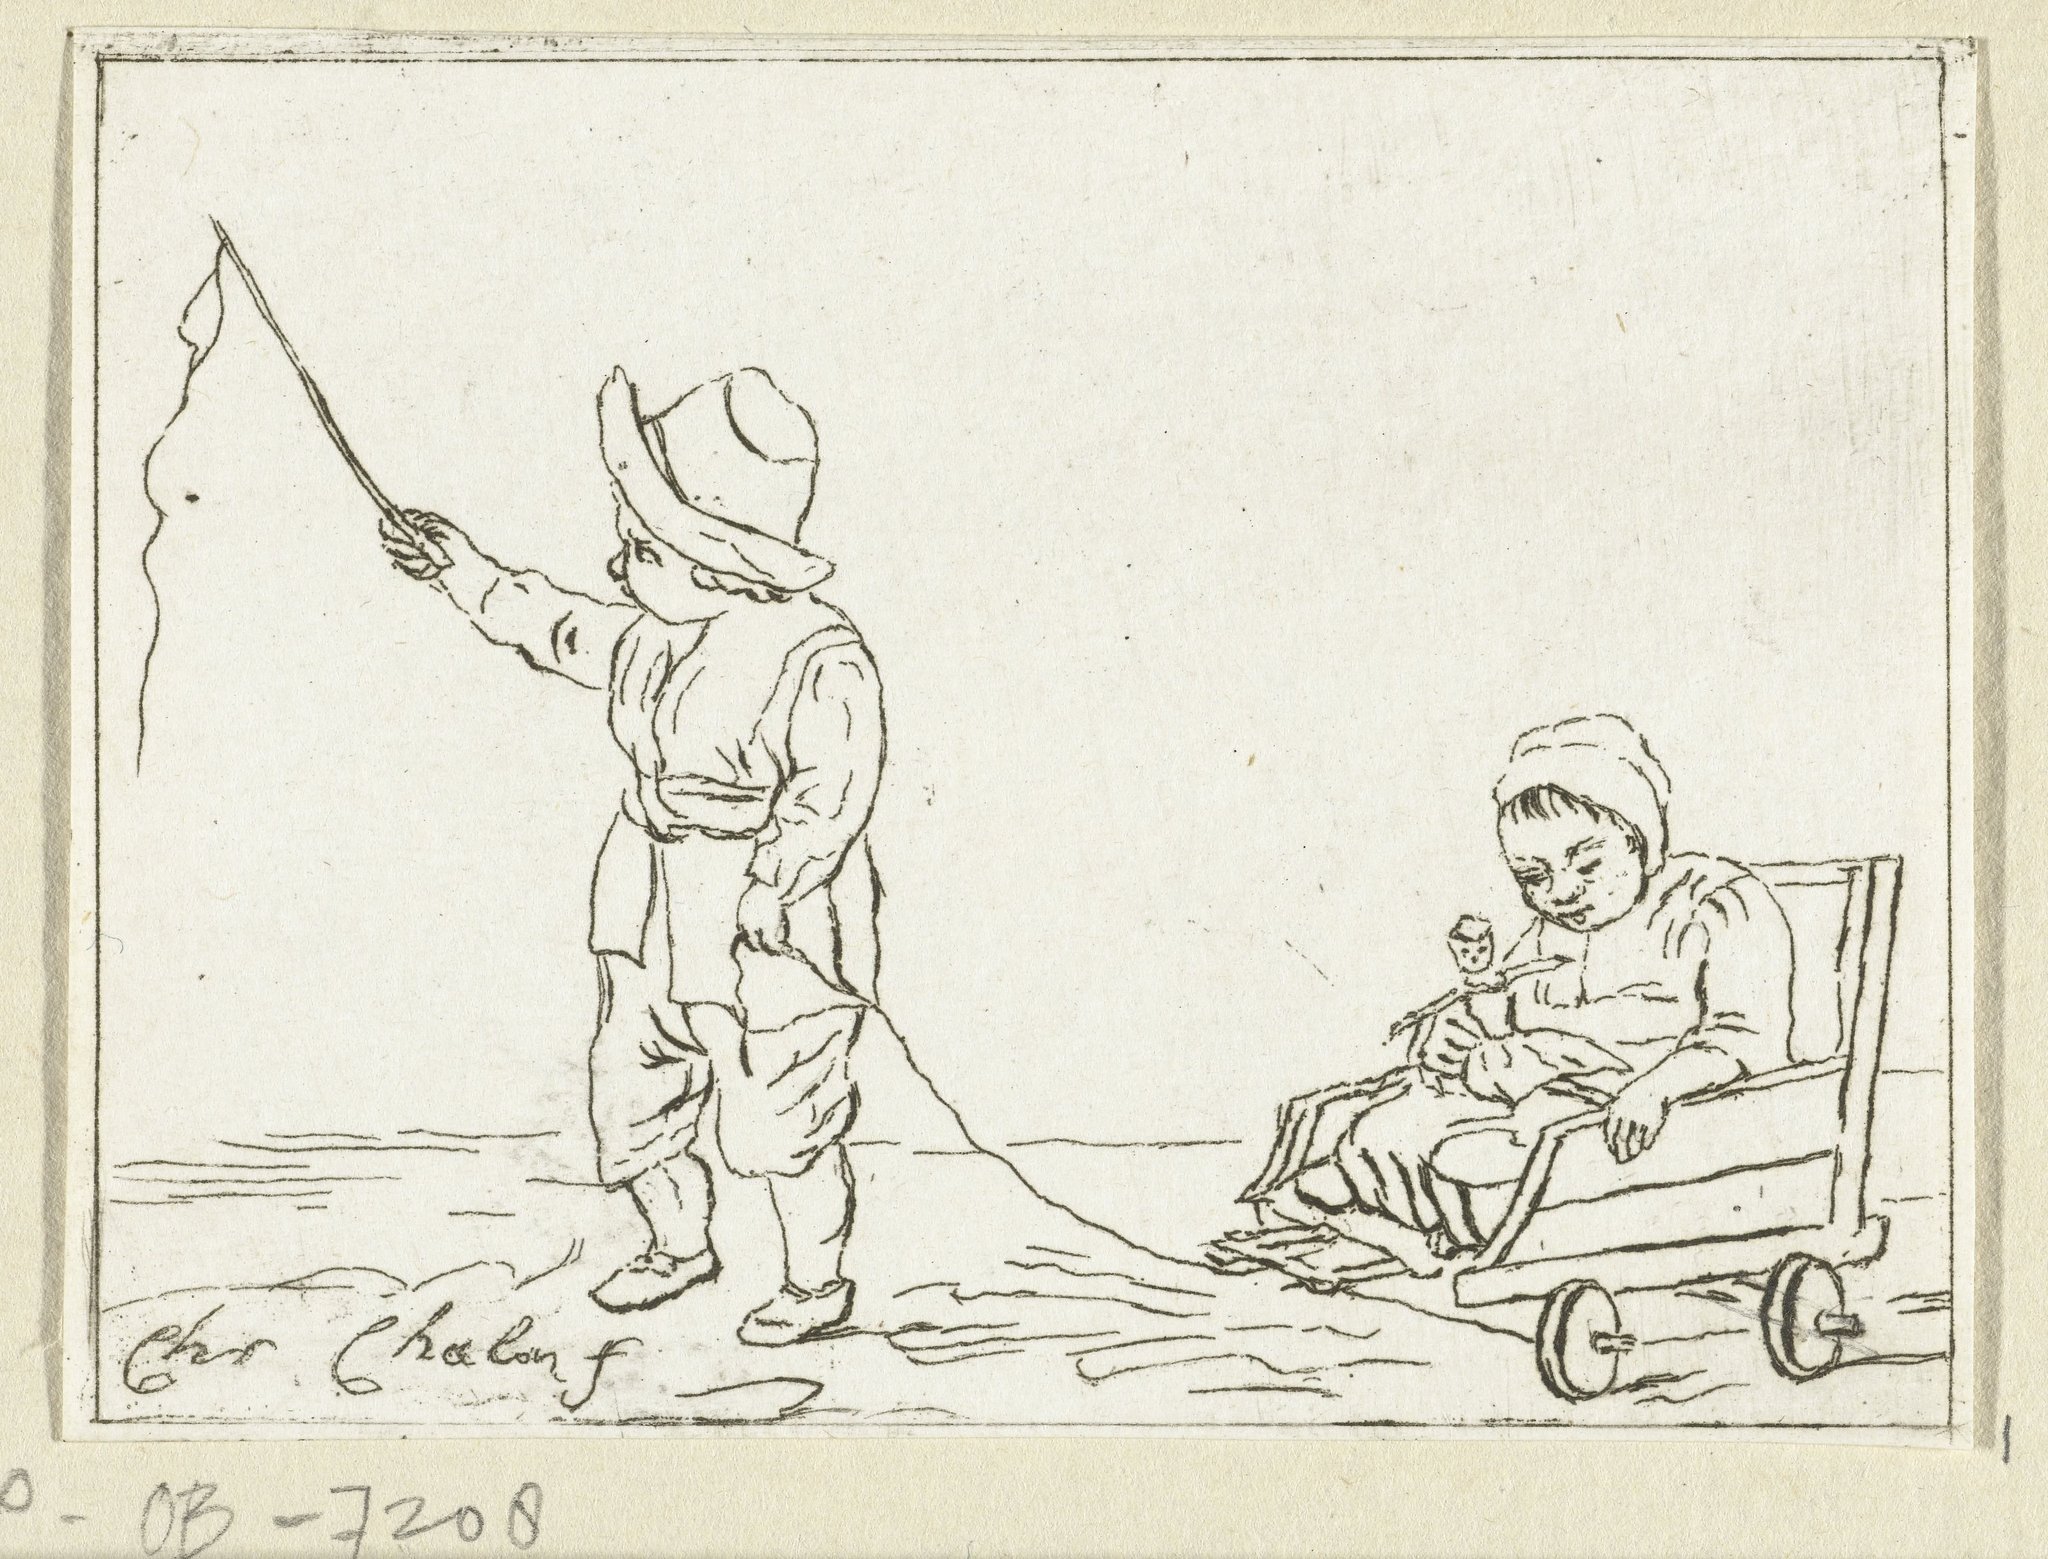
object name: print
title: Kinderen met kar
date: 1779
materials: paper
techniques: etching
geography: leiden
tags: (playing with) dolls, brothers or sisters (second degree family relationships), (playing with) barrow, wagon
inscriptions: collector's mark: Lugt 2228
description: Een jongetje en een meisje spelen koetsier en passagier. De jongen staat voor een rolkar en heeft een zweepje vast. Hij trekt de kar vooruit. Zijn zusje zit in de kar en speelt met een popje.